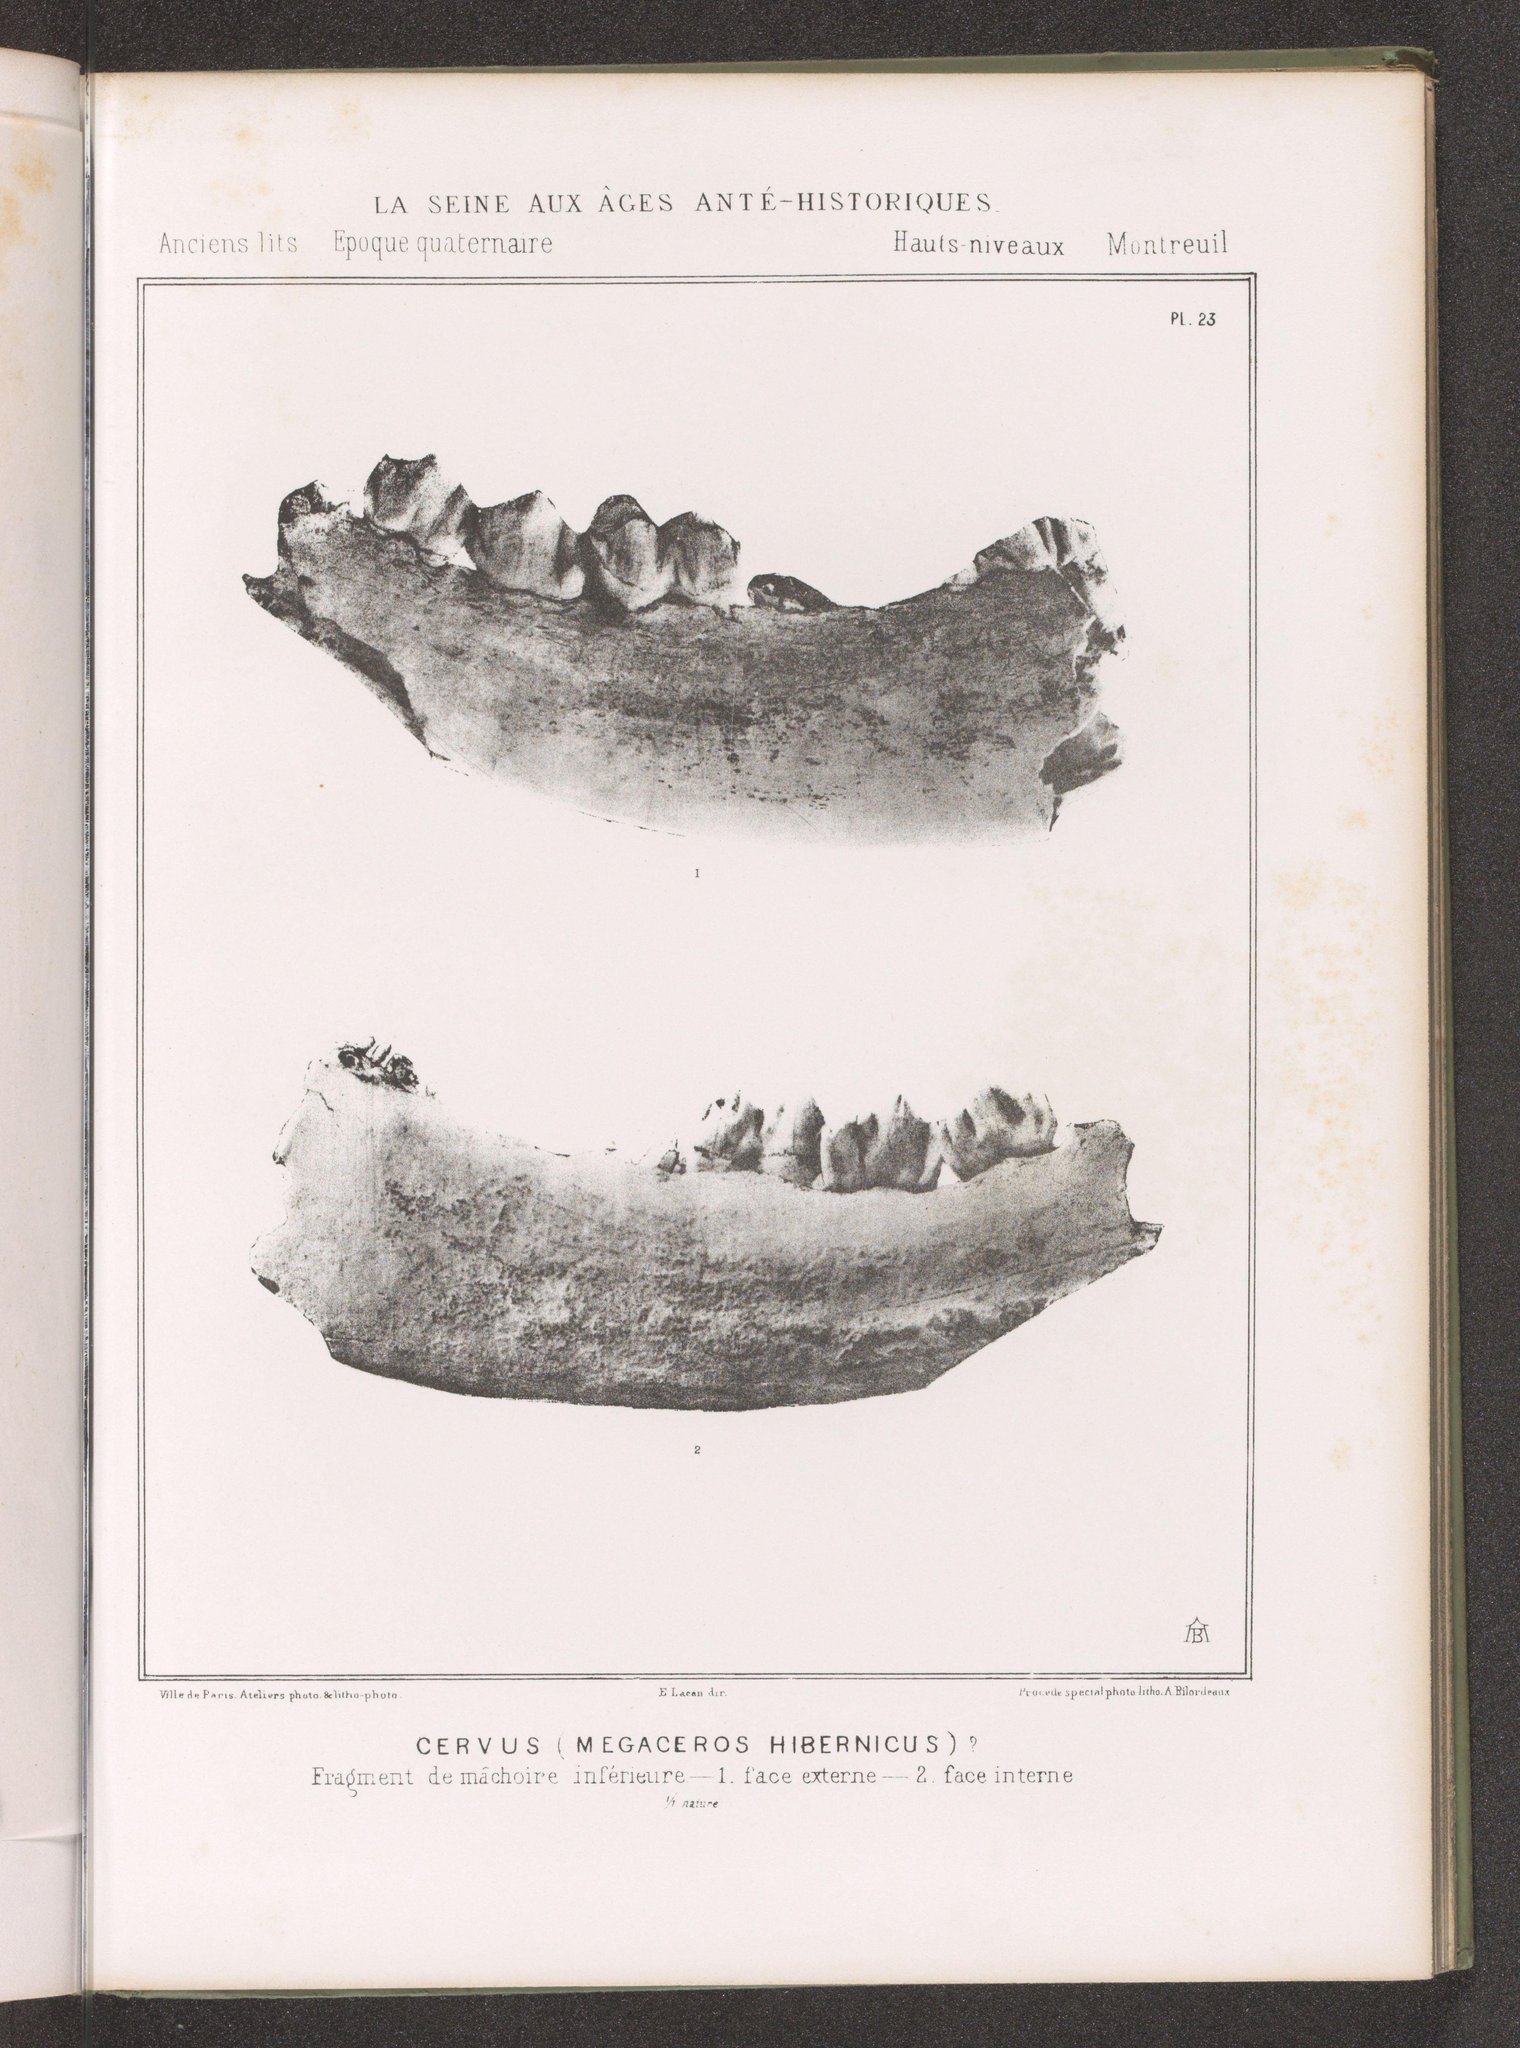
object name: page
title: Twee aanzichten van de onderkaak van een hert, binnenkant en buitenkant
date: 1860-1869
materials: paper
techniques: photolithography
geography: paris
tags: animals (+ skeleton of an animal), palaeontology, france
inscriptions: inscription: ‘Ville de Paris Ateliers photo & litho-photo. E. Lacan, dir. Procédé spécial photo-litho A. Bilordeaux’, number: ‘Pl. 23’, monogram: ‘AB’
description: Voor plek prent in boek: zie nummer onder 'Opschriften / Merken'.